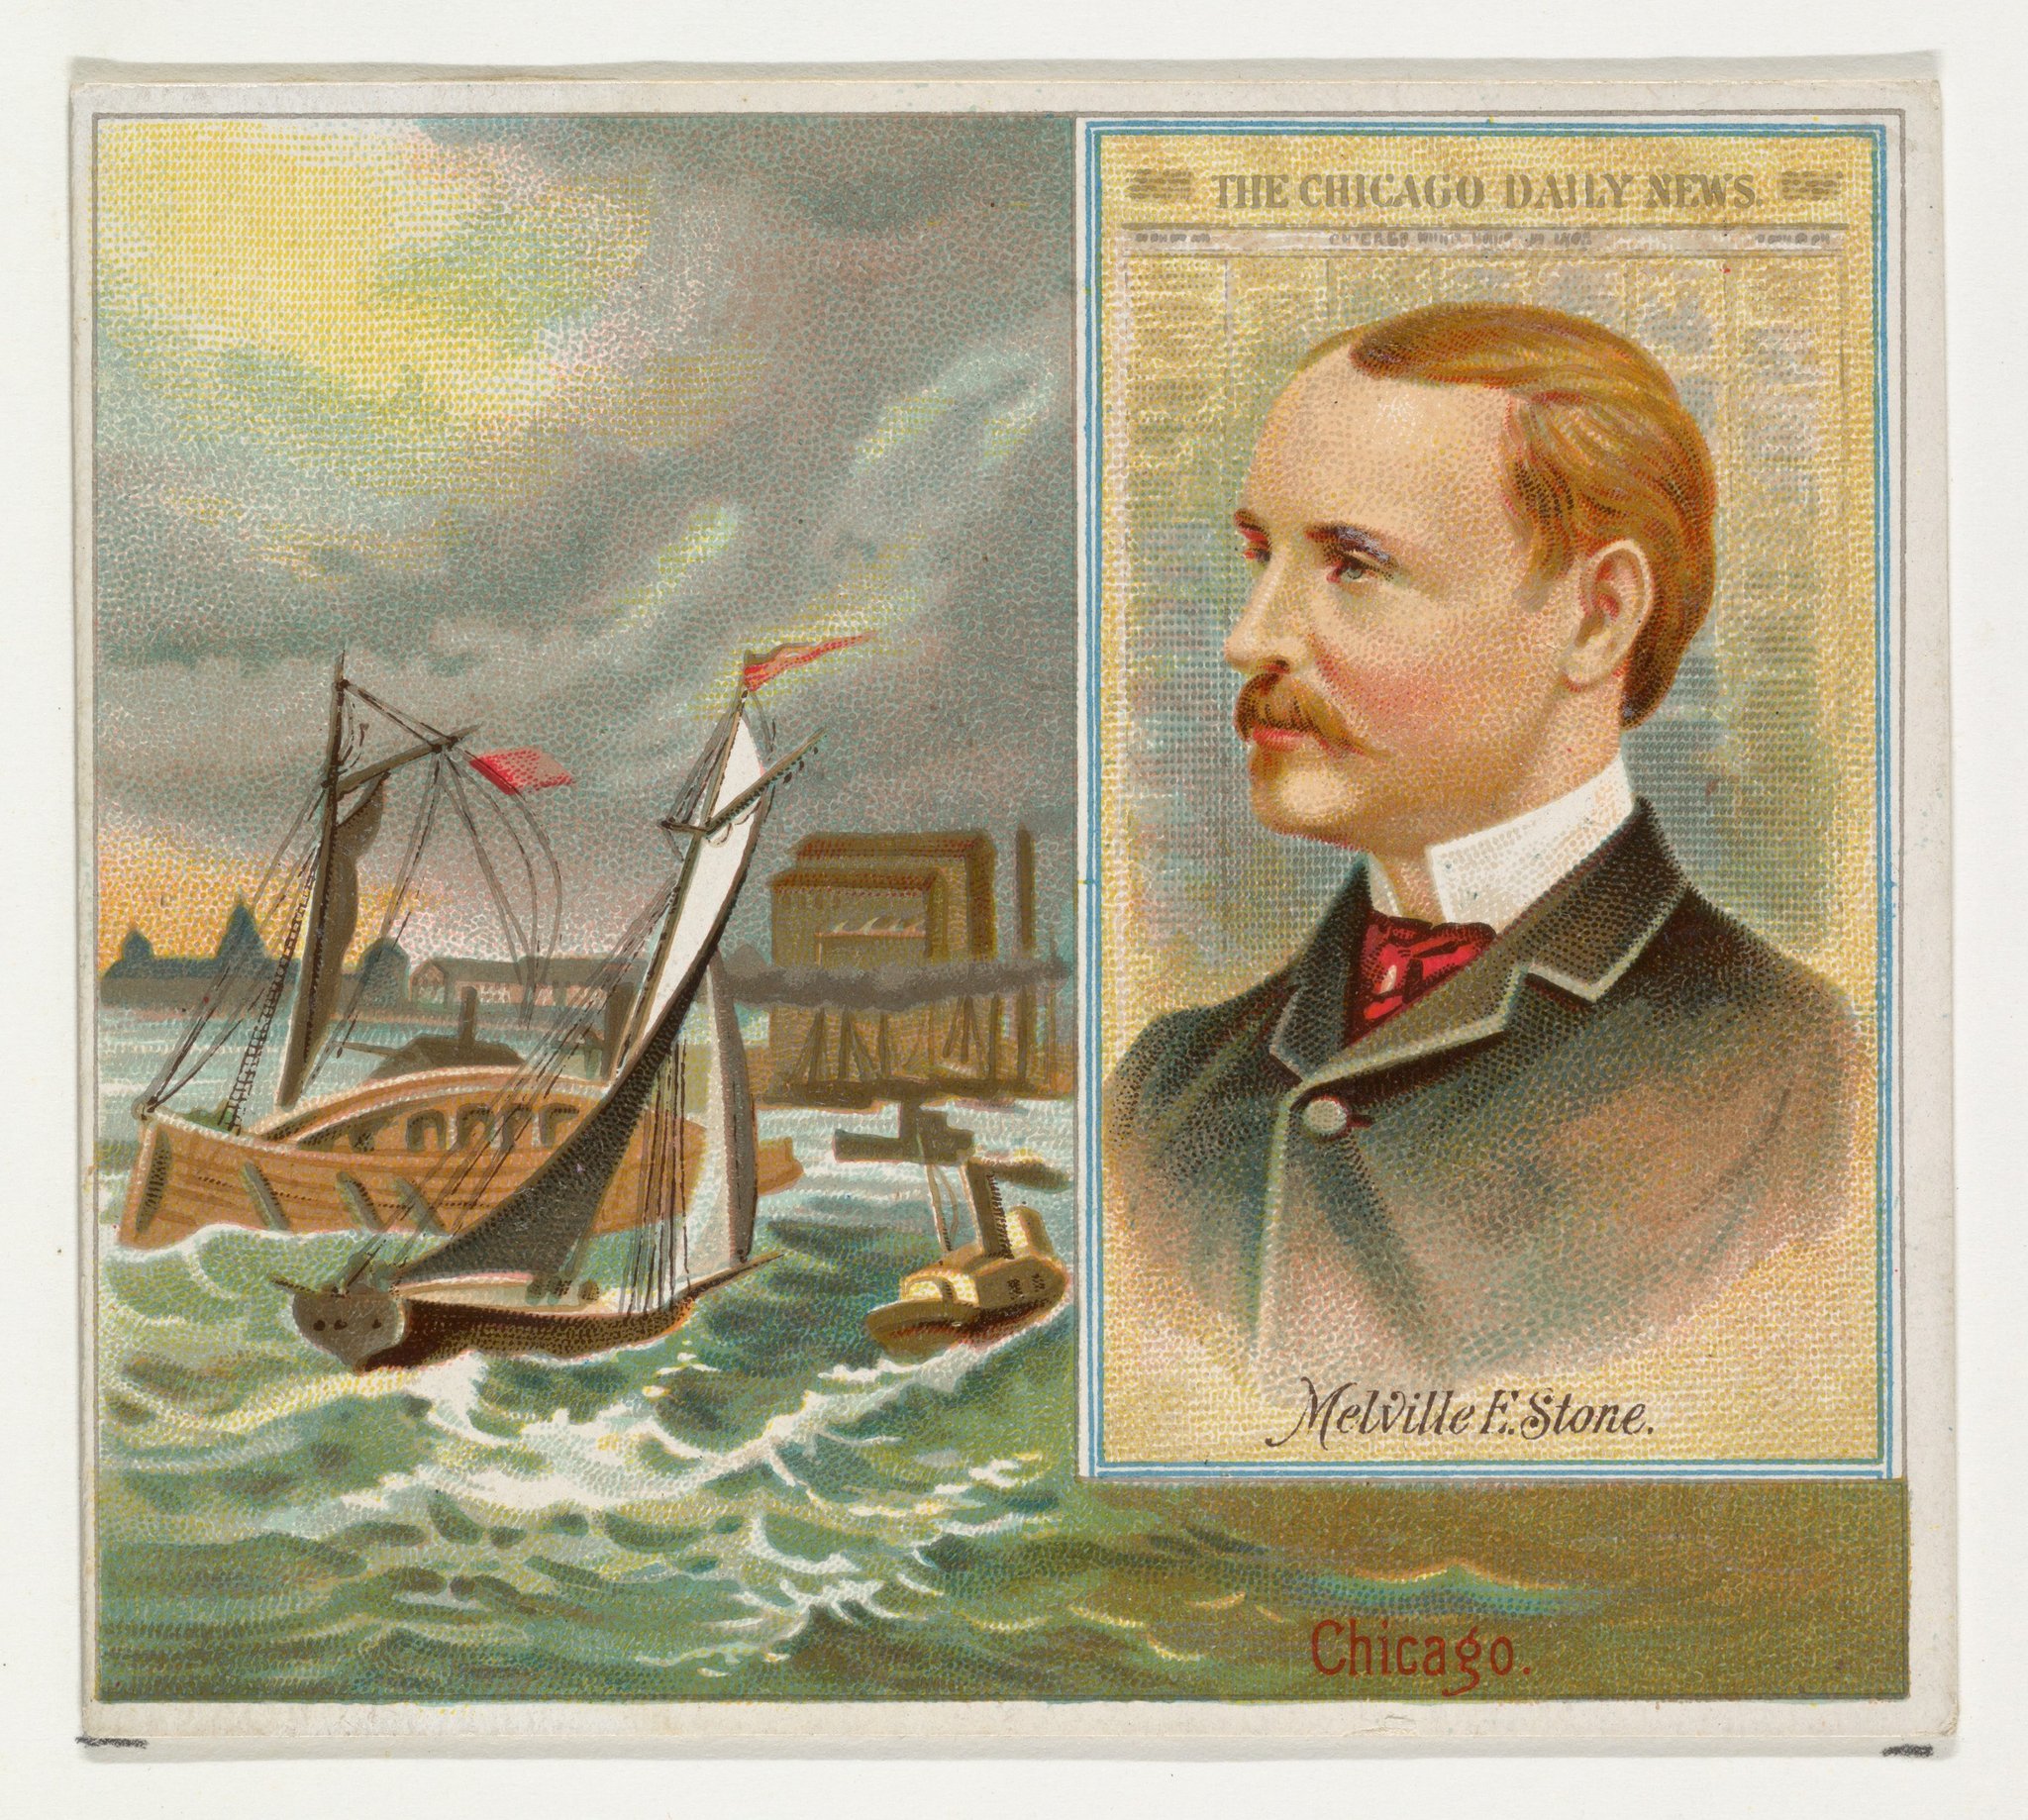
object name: print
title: Melville E. Stone, The Chicago Daily News, from the American Editors series (N35) for Allen & Ginter Cigarettes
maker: allen & ginter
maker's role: publisher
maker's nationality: american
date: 1887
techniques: color lithograph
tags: men,ships